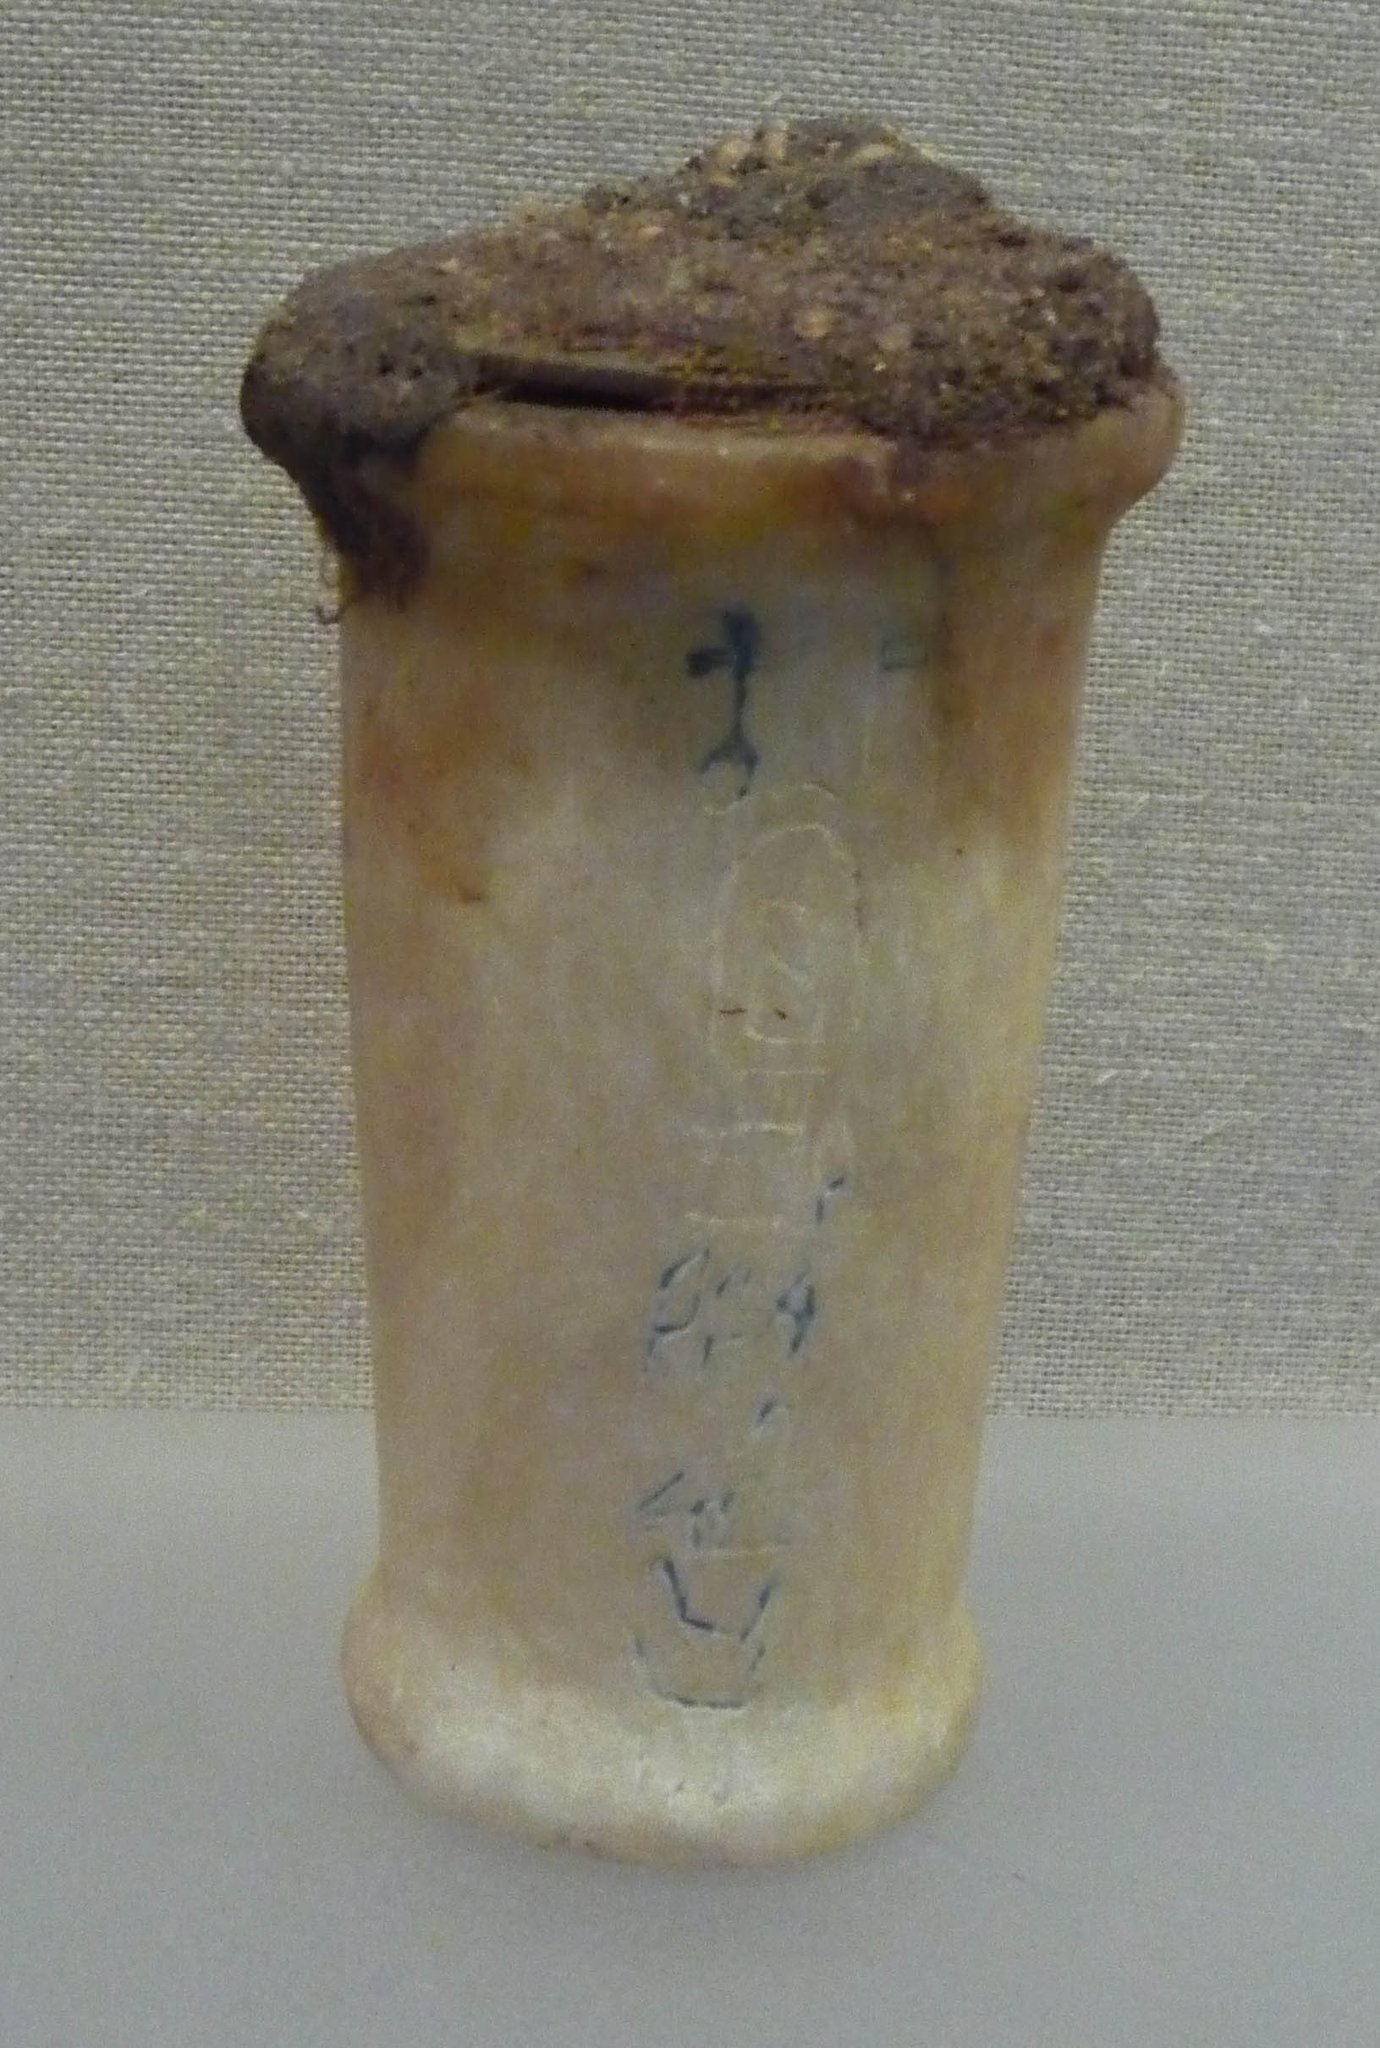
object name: ointment jar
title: Inscribed Ointment Jar From Foundation Deposit 2 of Hatshepsut's Valley Temple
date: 1479-1458 BCE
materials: linen, stone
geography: egypt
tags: hieroglyphs